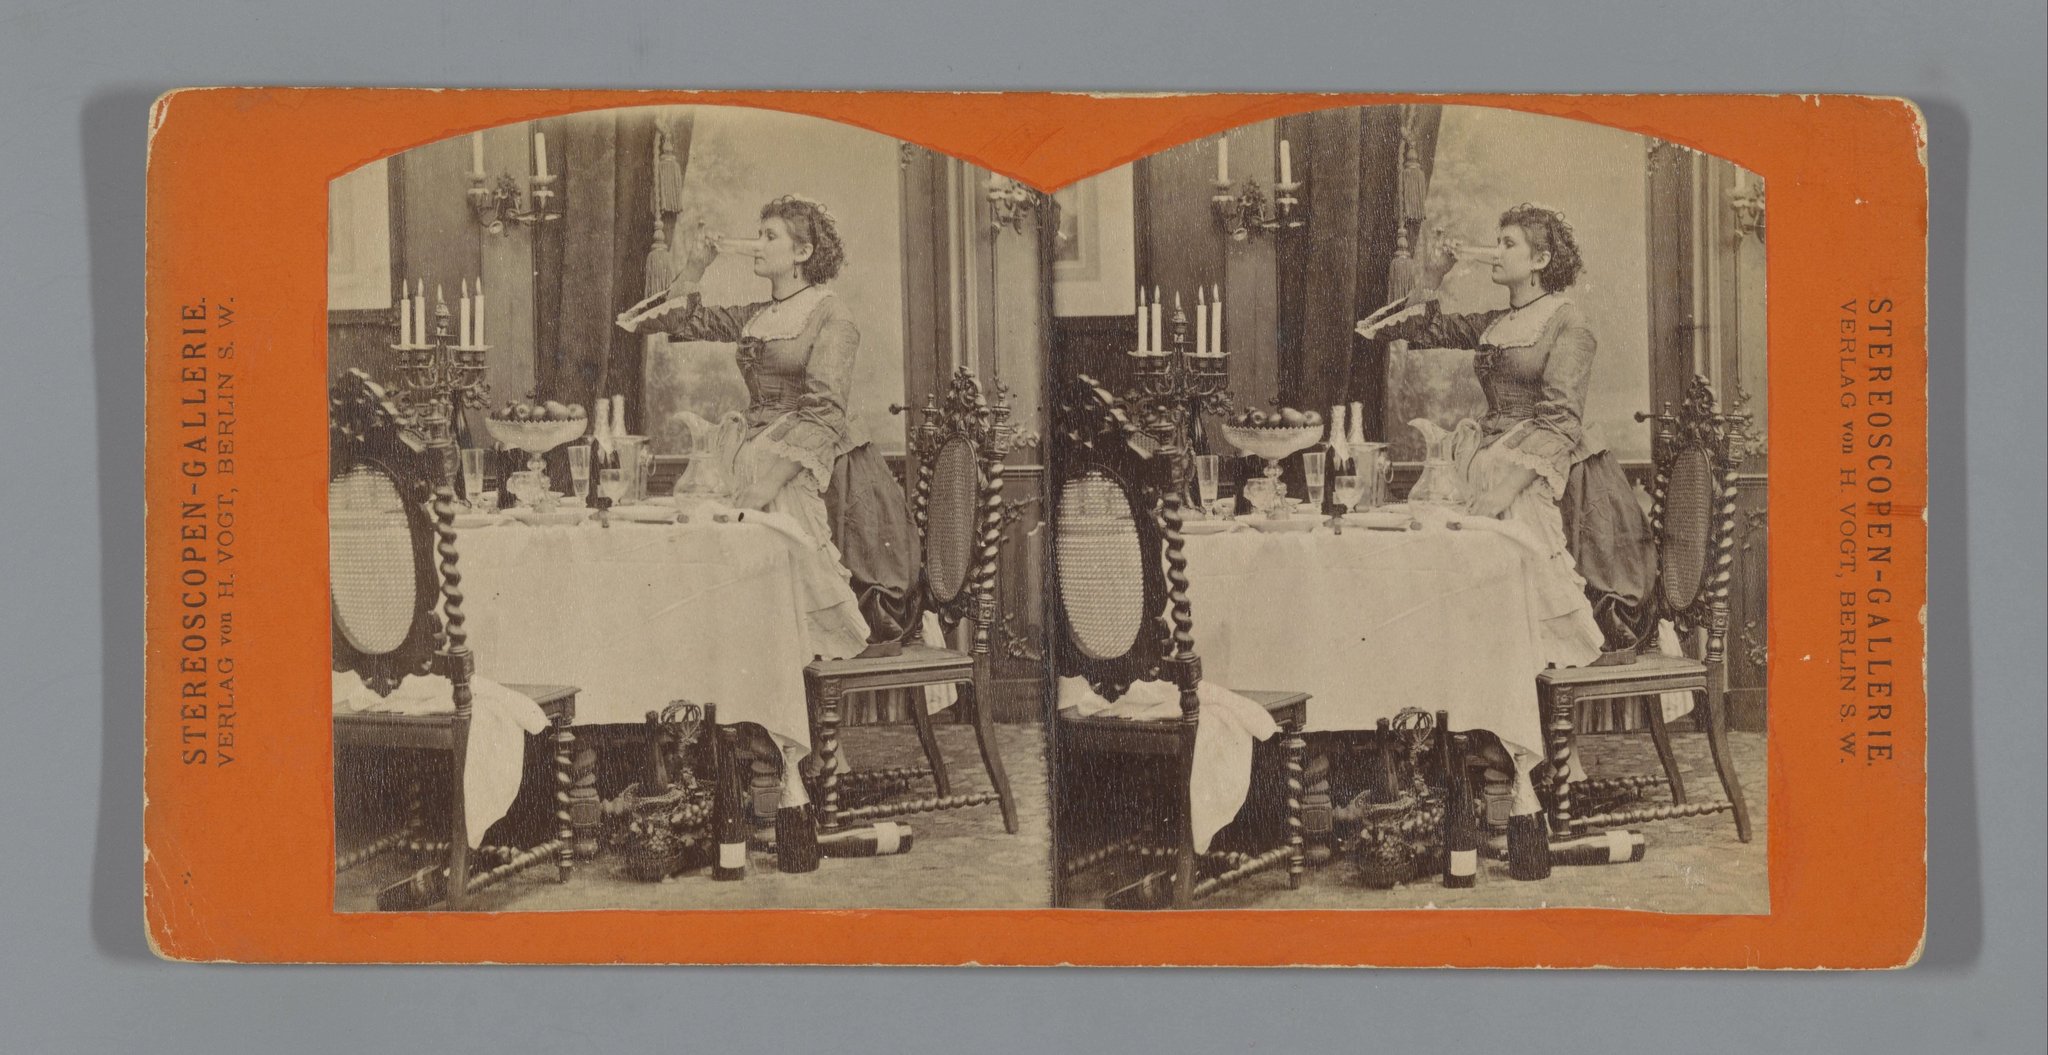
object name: stereograph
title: Jonge vrouw staat drinkend bij tafel met champagneflessen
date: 1870-1880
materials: cardboard, photographic support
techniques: albumen print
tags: wine ~ alcoholic drinks, glass of wine, living-room, parlour, sitting-room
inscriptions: : ‘Stereoscopen-Gallerie. Berlin S.W.’